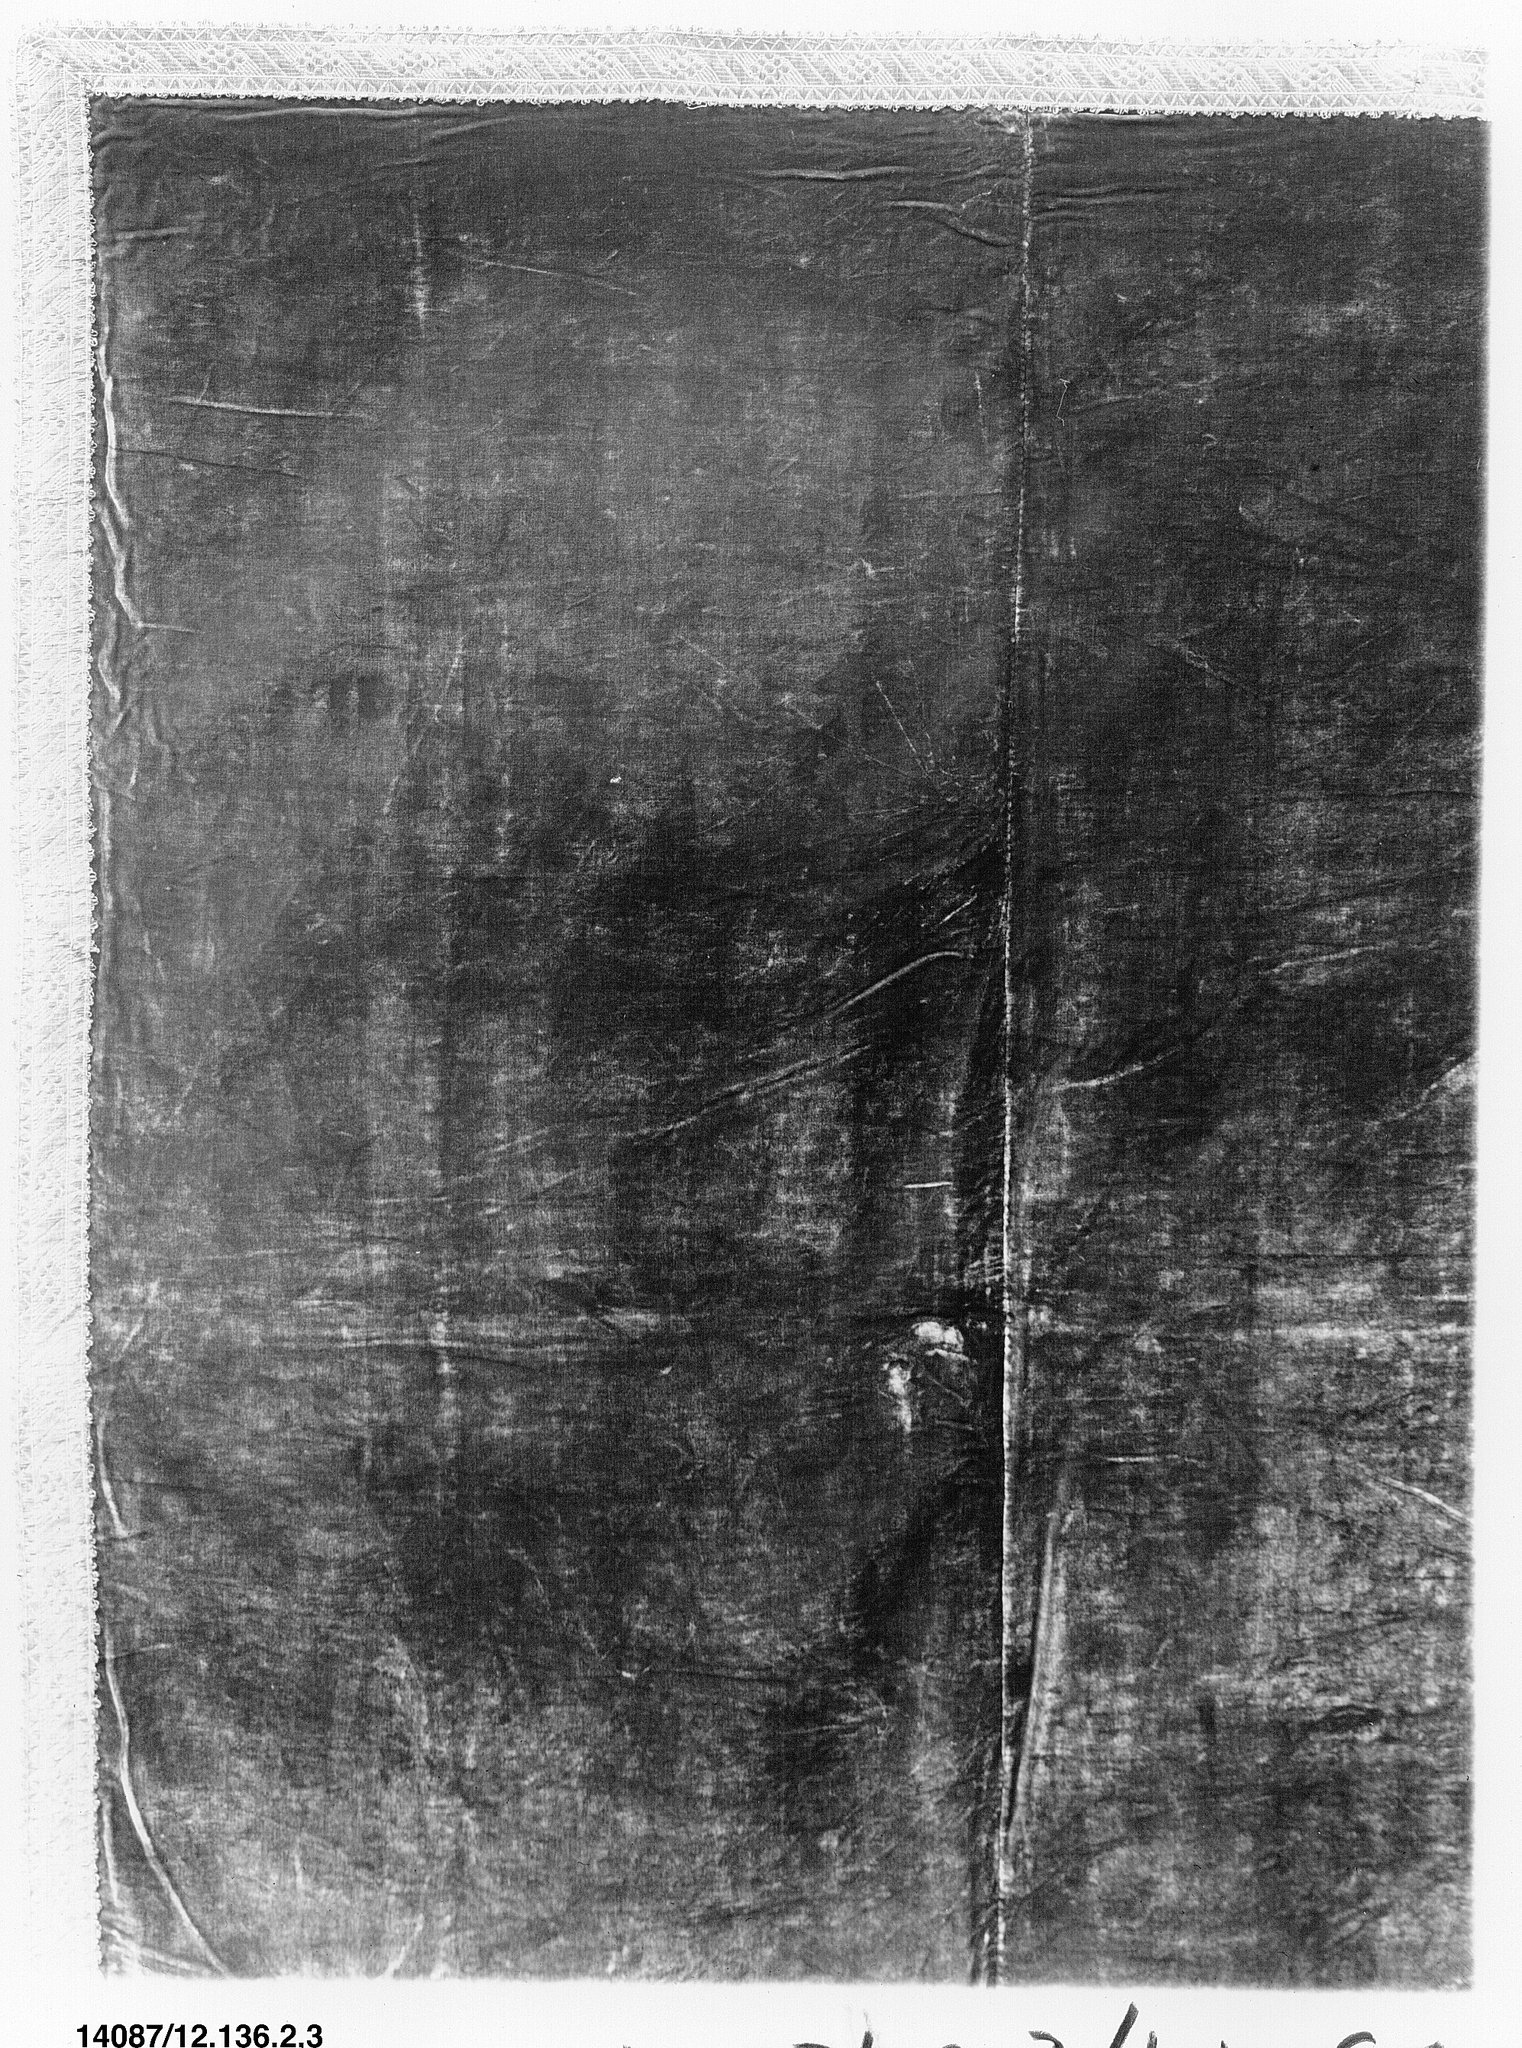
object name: hanging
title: Hangings (2)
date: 1501-1700